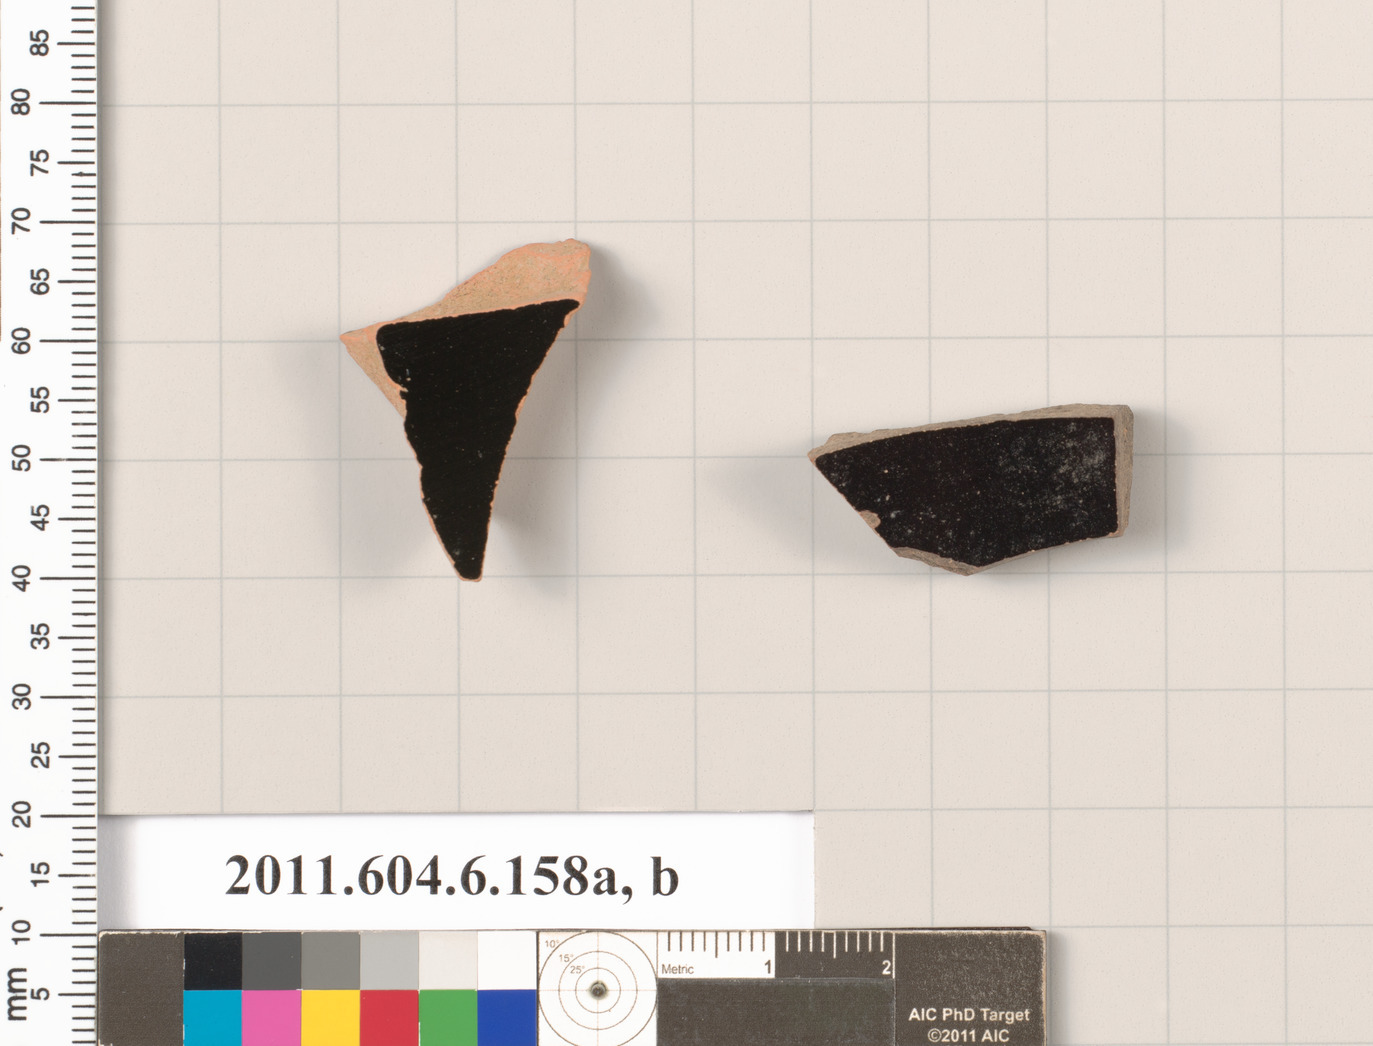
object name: undetermined open shape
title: Terracotta fragments of open shapes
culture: greek, attic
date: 600-401 BCE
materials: terracotta